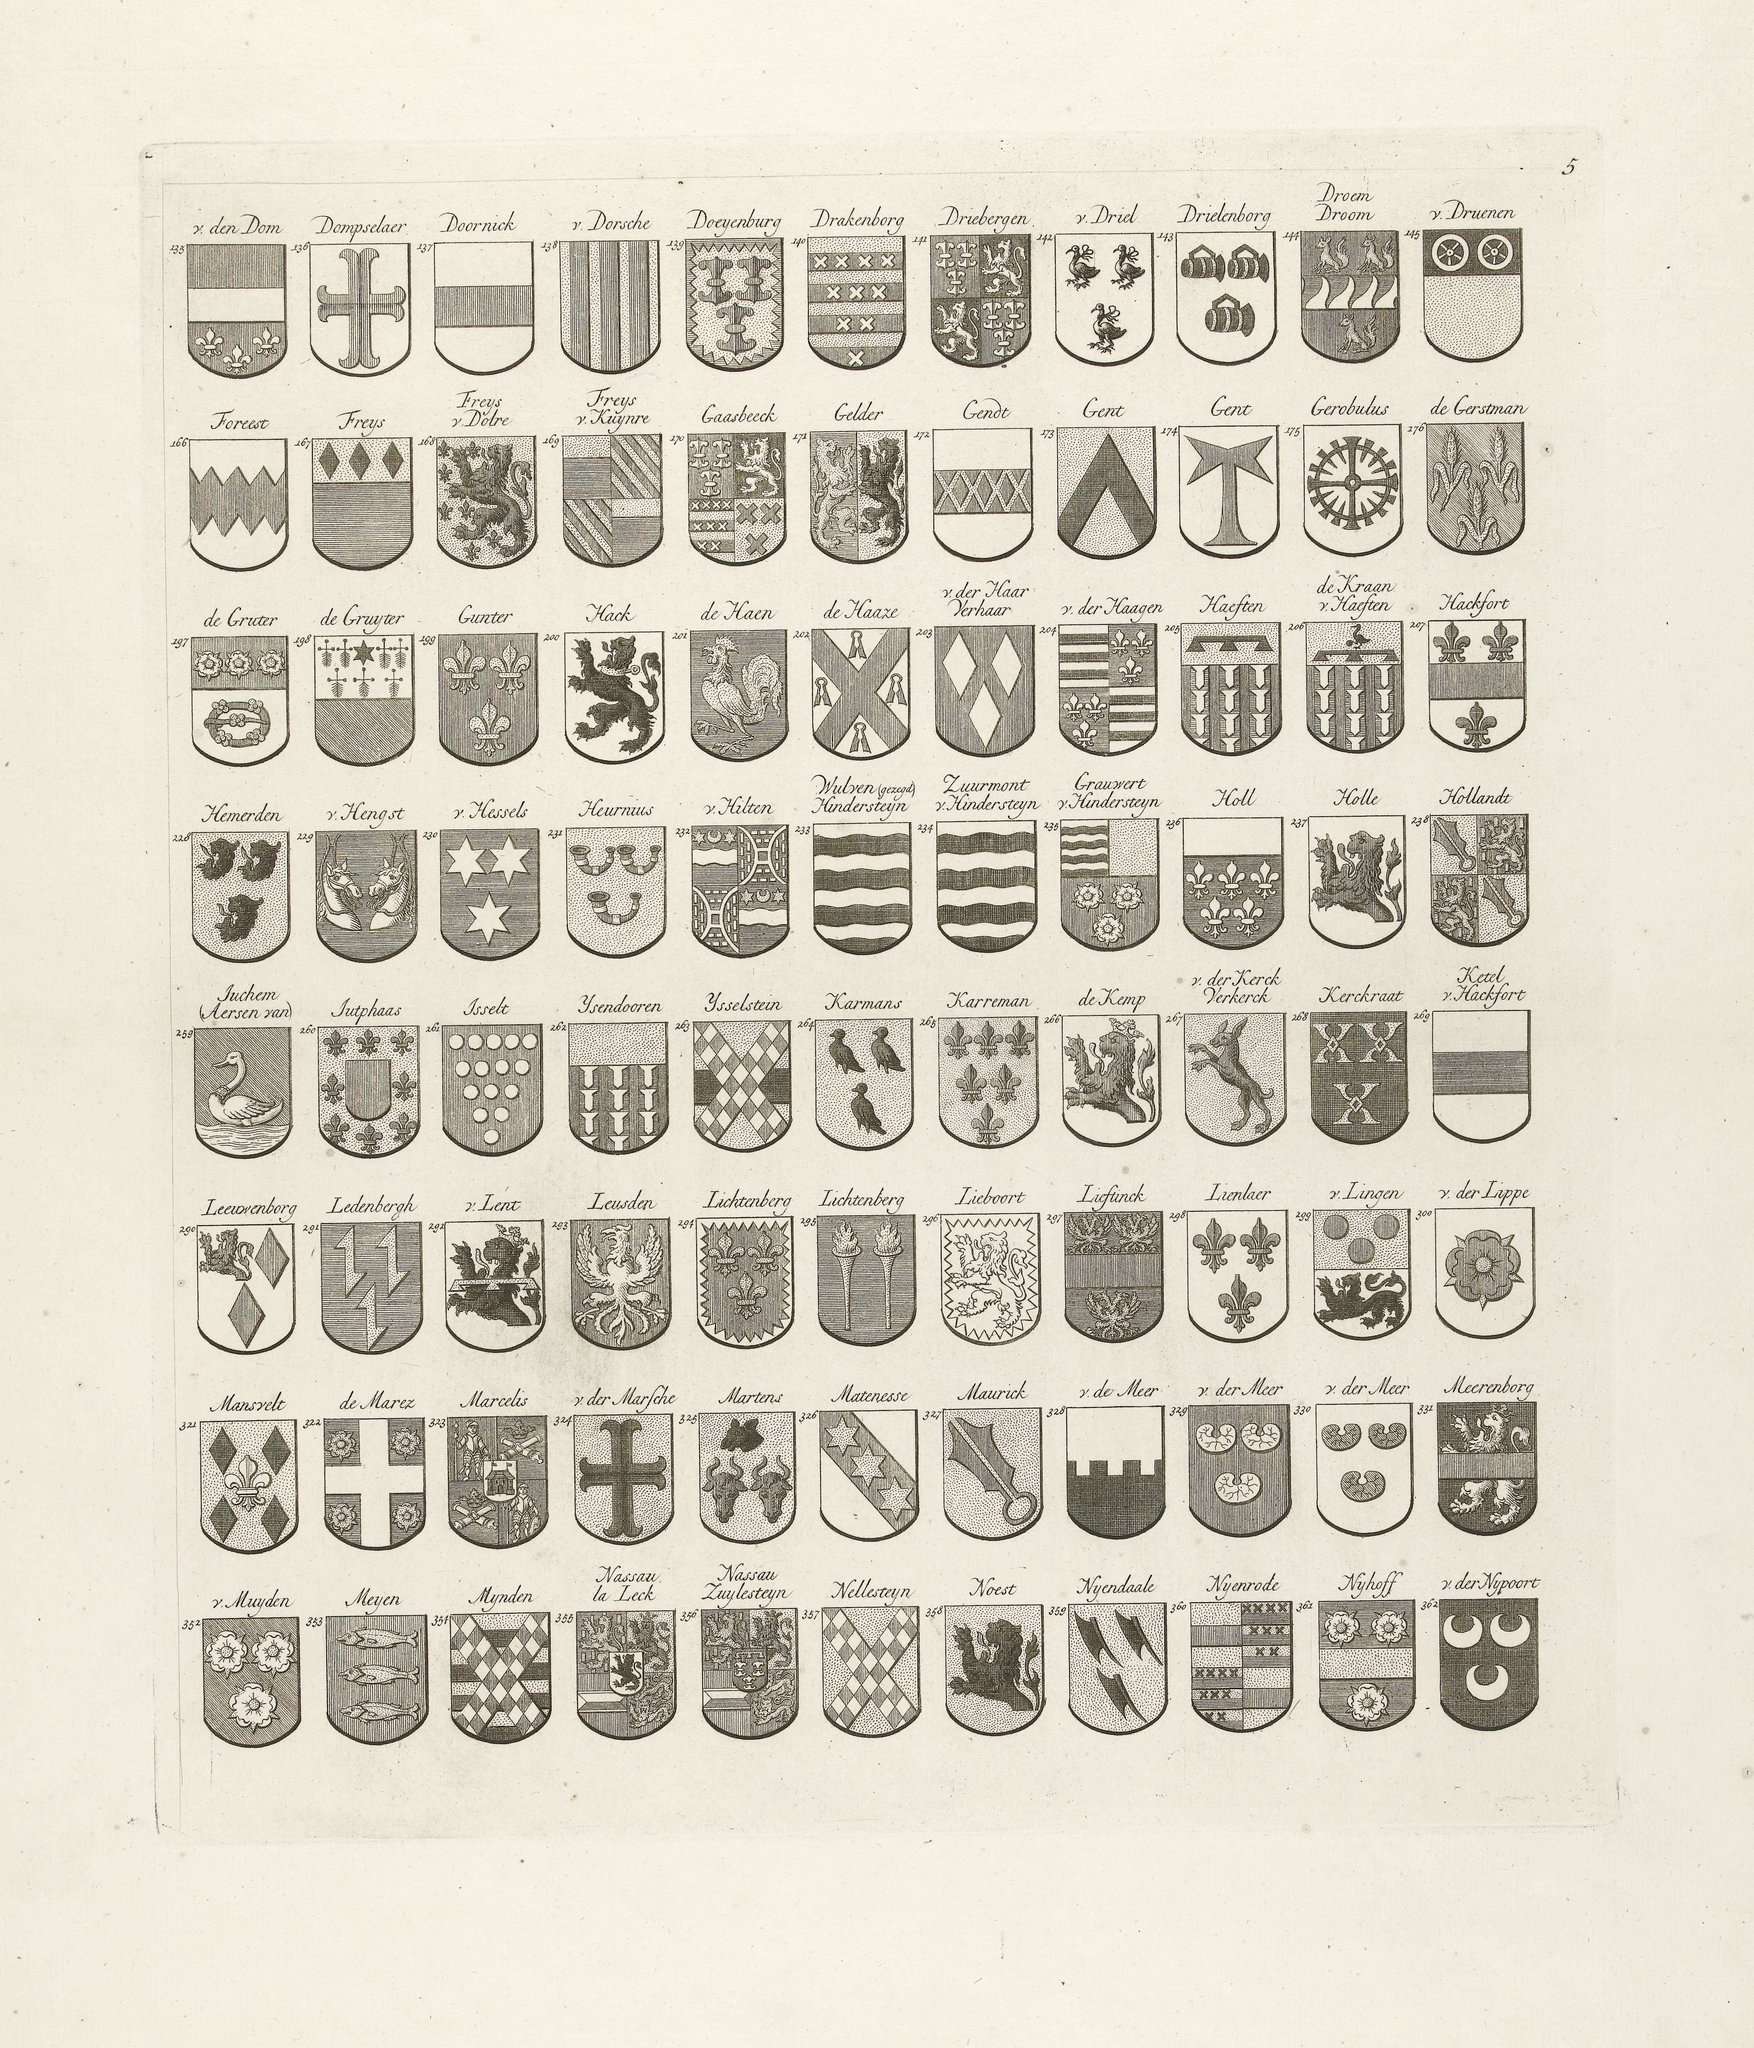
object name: print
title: Wapenkaart van oude geslachten van Utrecht, middenblad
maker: johannes van hiltrop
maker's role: print maker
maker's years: 1764-1814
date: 1769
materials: paper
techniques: etching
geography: utrecht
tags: armorial bearing, heraldry, utrecht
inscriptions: collector's mark: Lugt 2228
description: Middenblad van een geheel van negen prenten, allen met wapens van oude geslachten uit Utrecht.